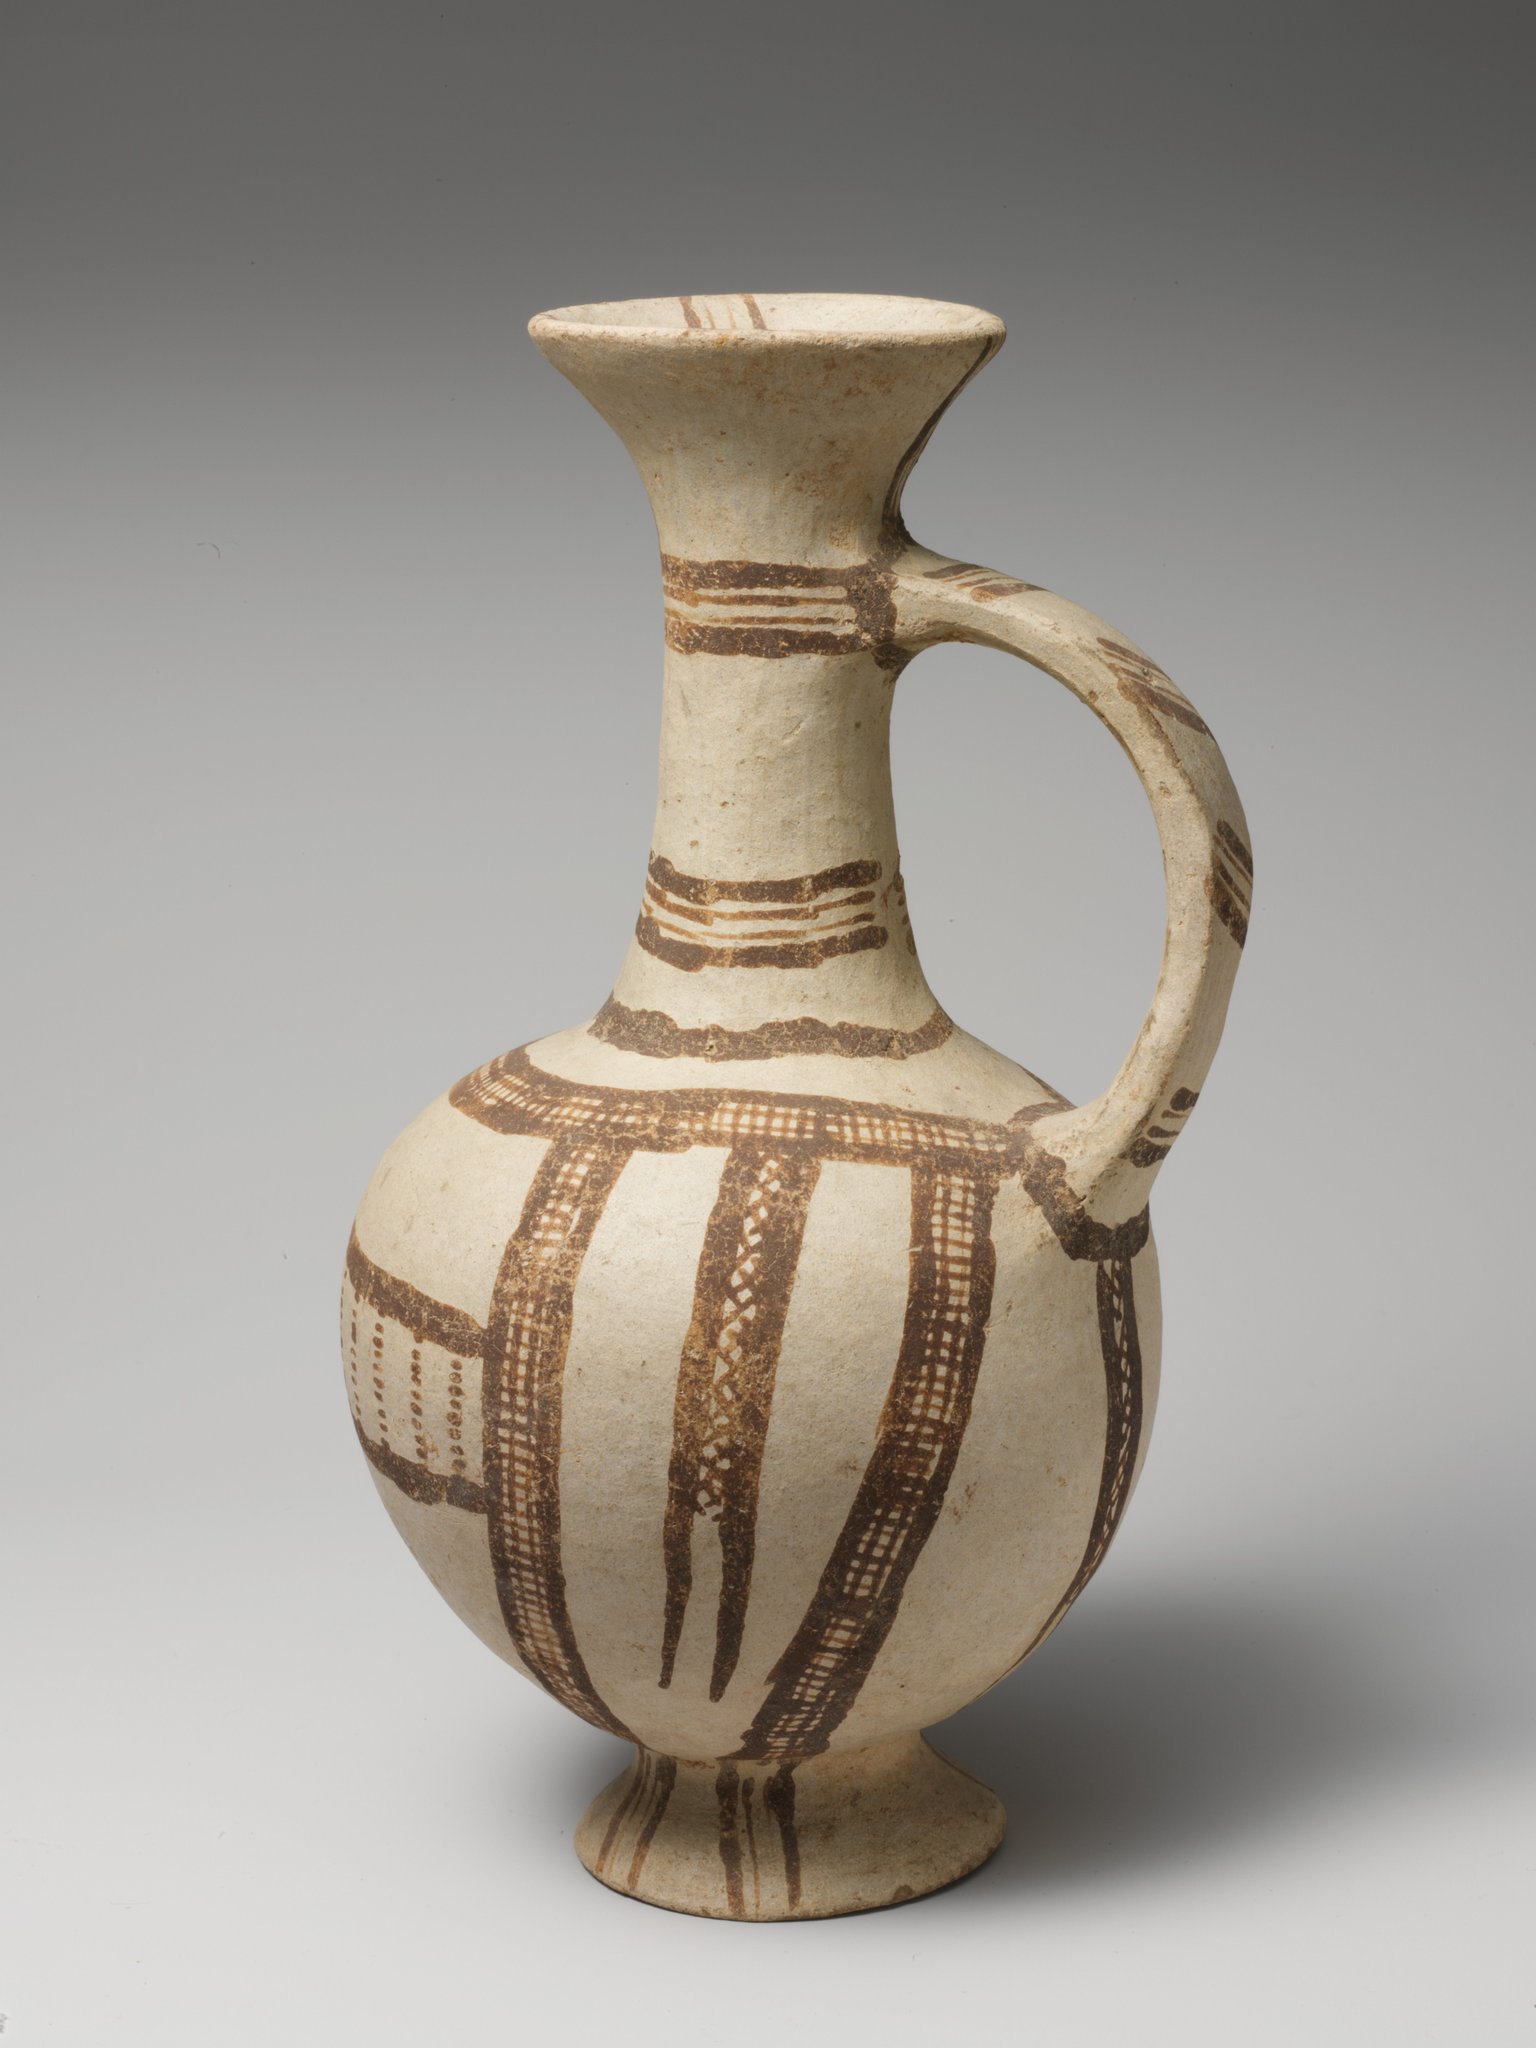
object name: jug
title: Terracotta jug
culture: cypriot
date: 1600-1200 BCE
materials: terracotta